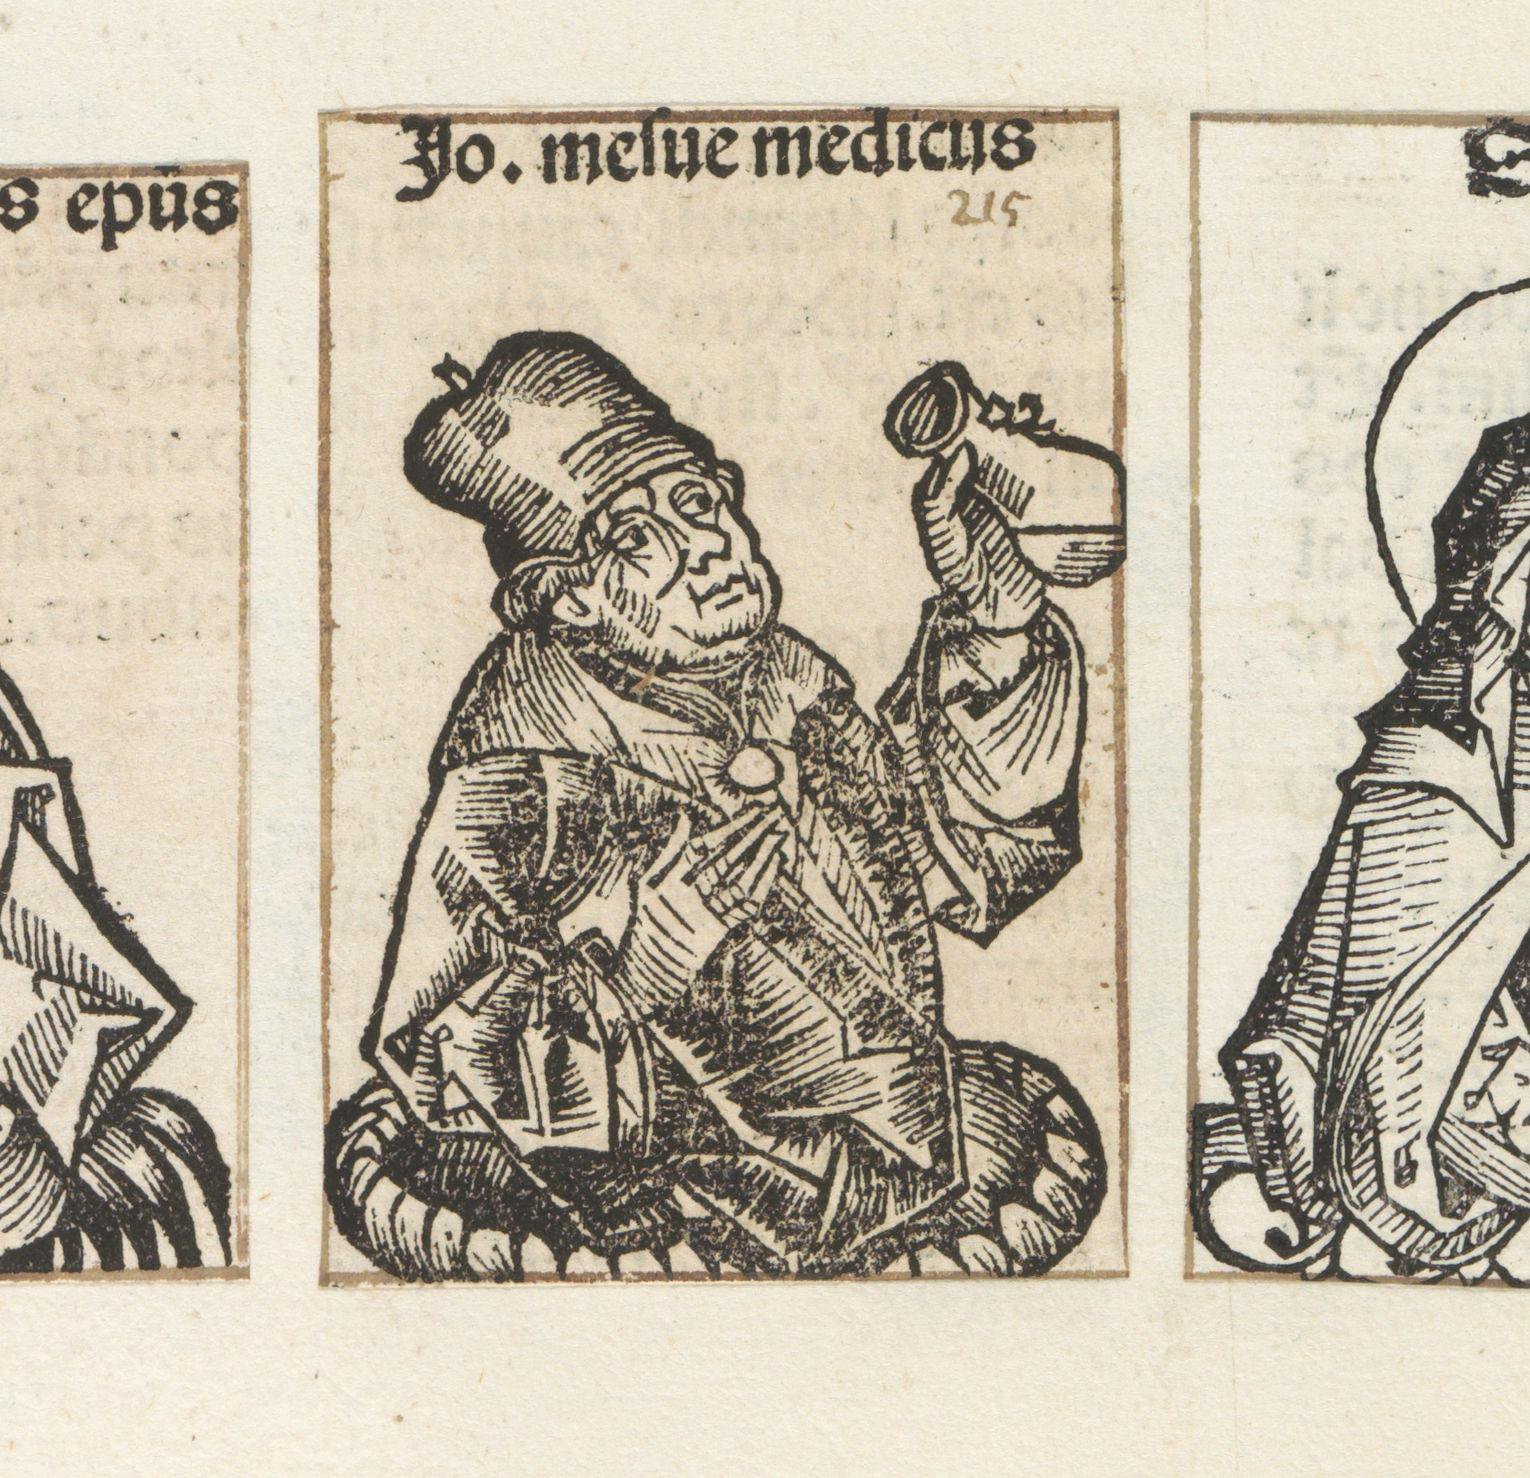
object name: print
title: Masawaiyh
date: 1493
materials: paper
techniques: letterpress printing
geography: nuremberg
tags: examination of urine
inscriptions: inscription: ‘215’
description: De houtsnede wordt herhaaldelijk gebruikt als boekillustratie in de Liber Chronicarum (of Neurenbergkroniek) van Hartmann Schedel, verschenen in het Latijn en Duits in 1493. Zie de Latijnse uitgave, folio 203v.